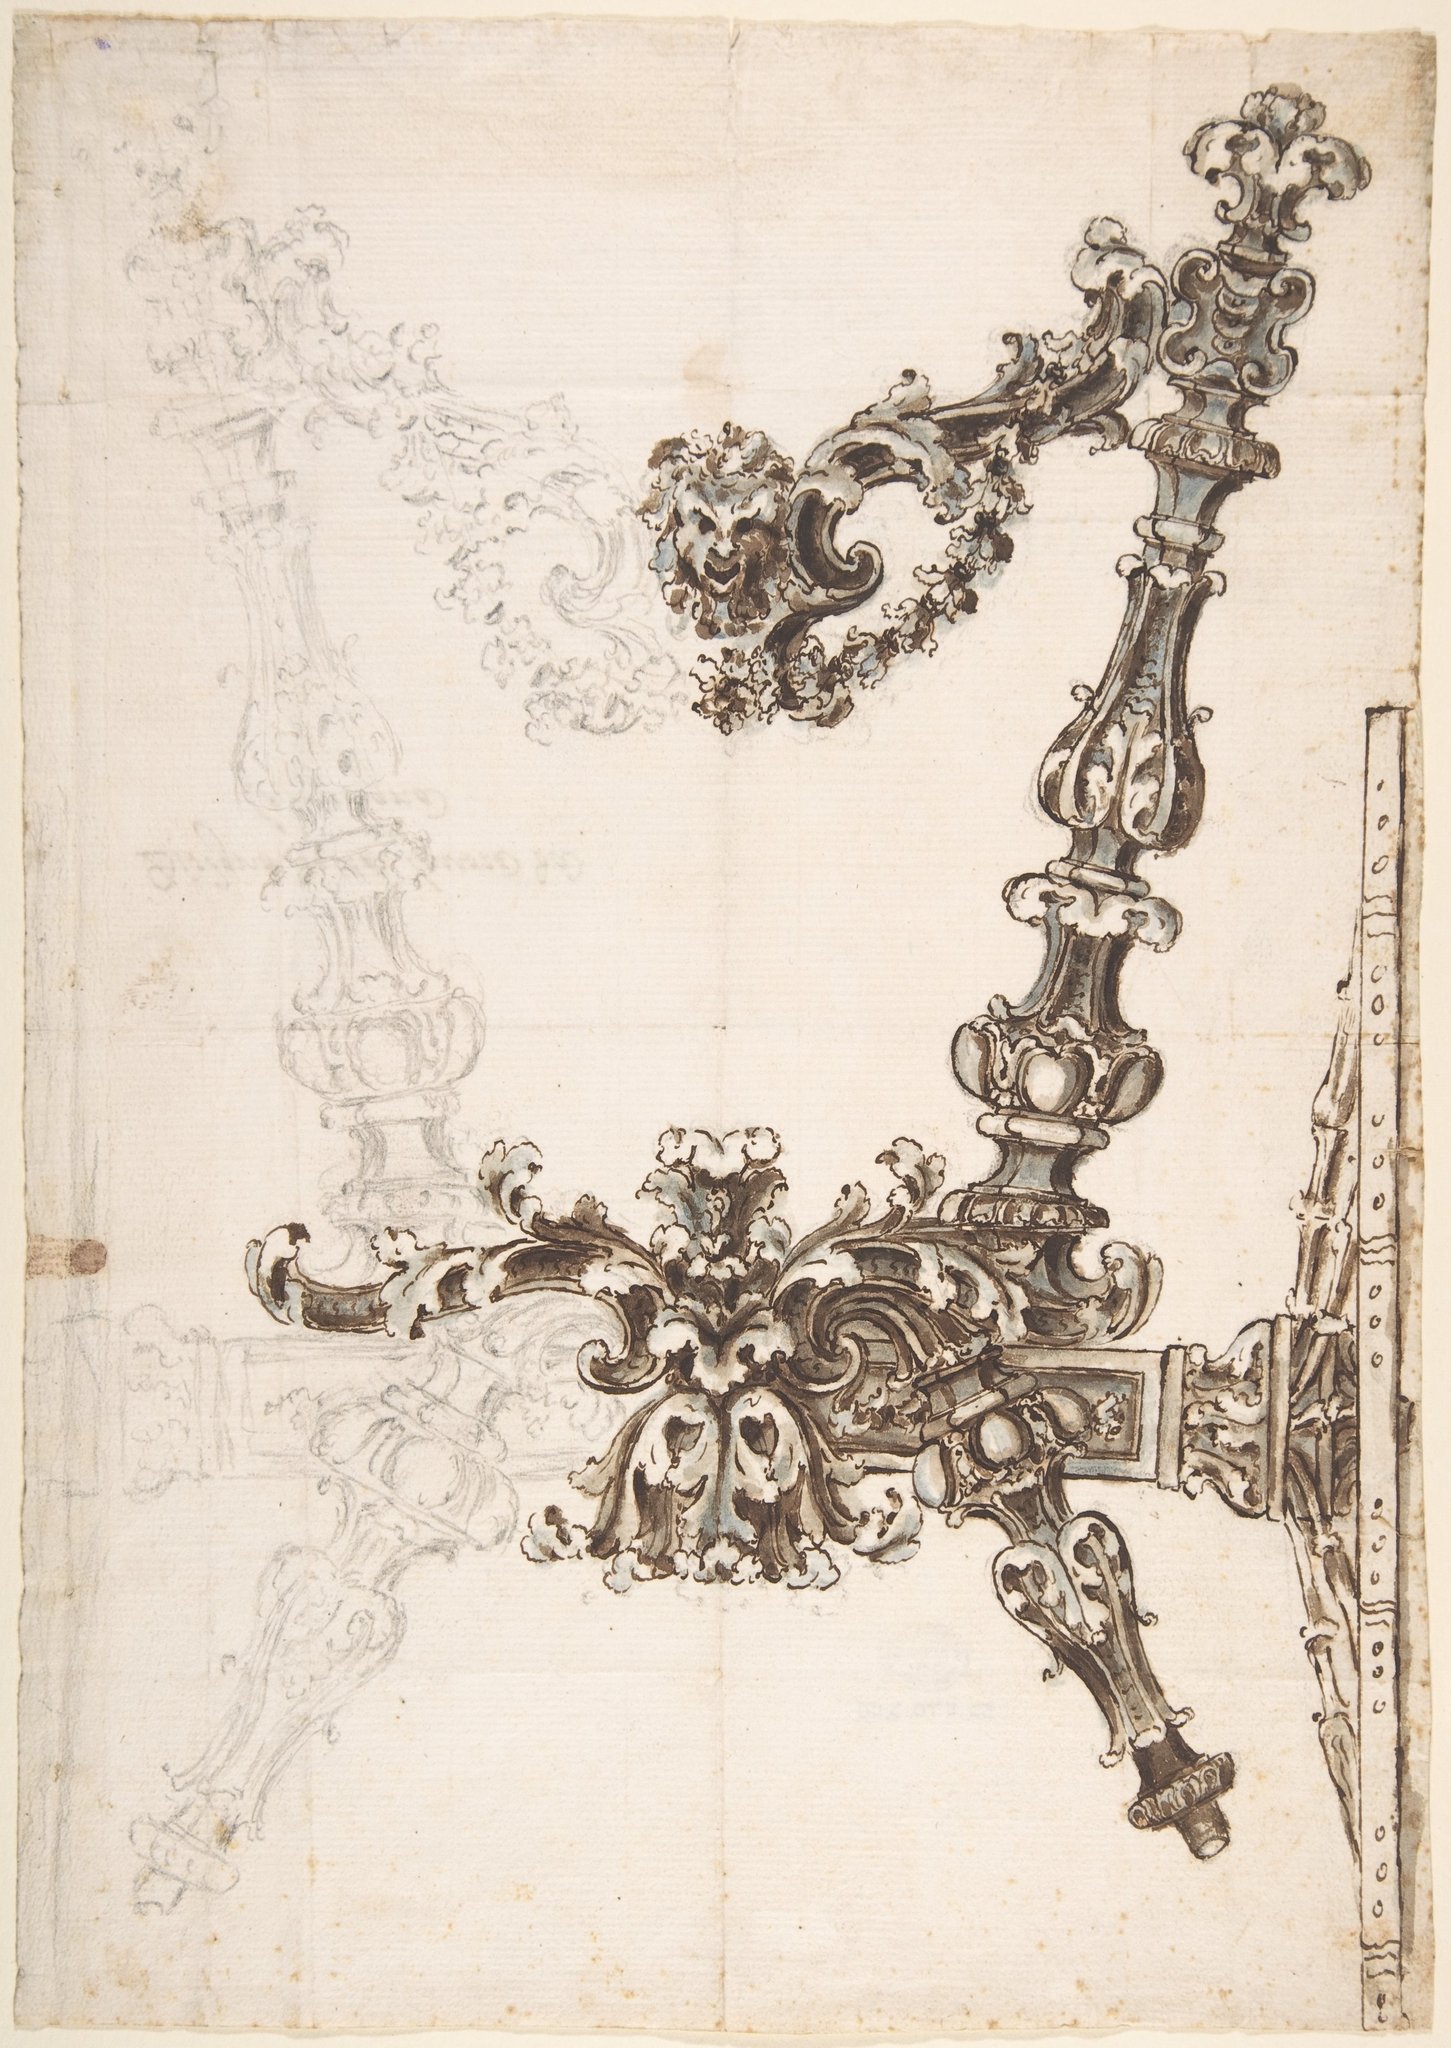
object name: drawing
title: Frontal View of the Main Carved Wooden Structure of a Carriage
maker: anonymous, italian, late 17th to early 18th century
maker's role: artist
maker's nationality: italian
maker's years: 1650-1750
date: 1675-1725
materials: ink, drawing material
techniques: pen, wash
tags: faces